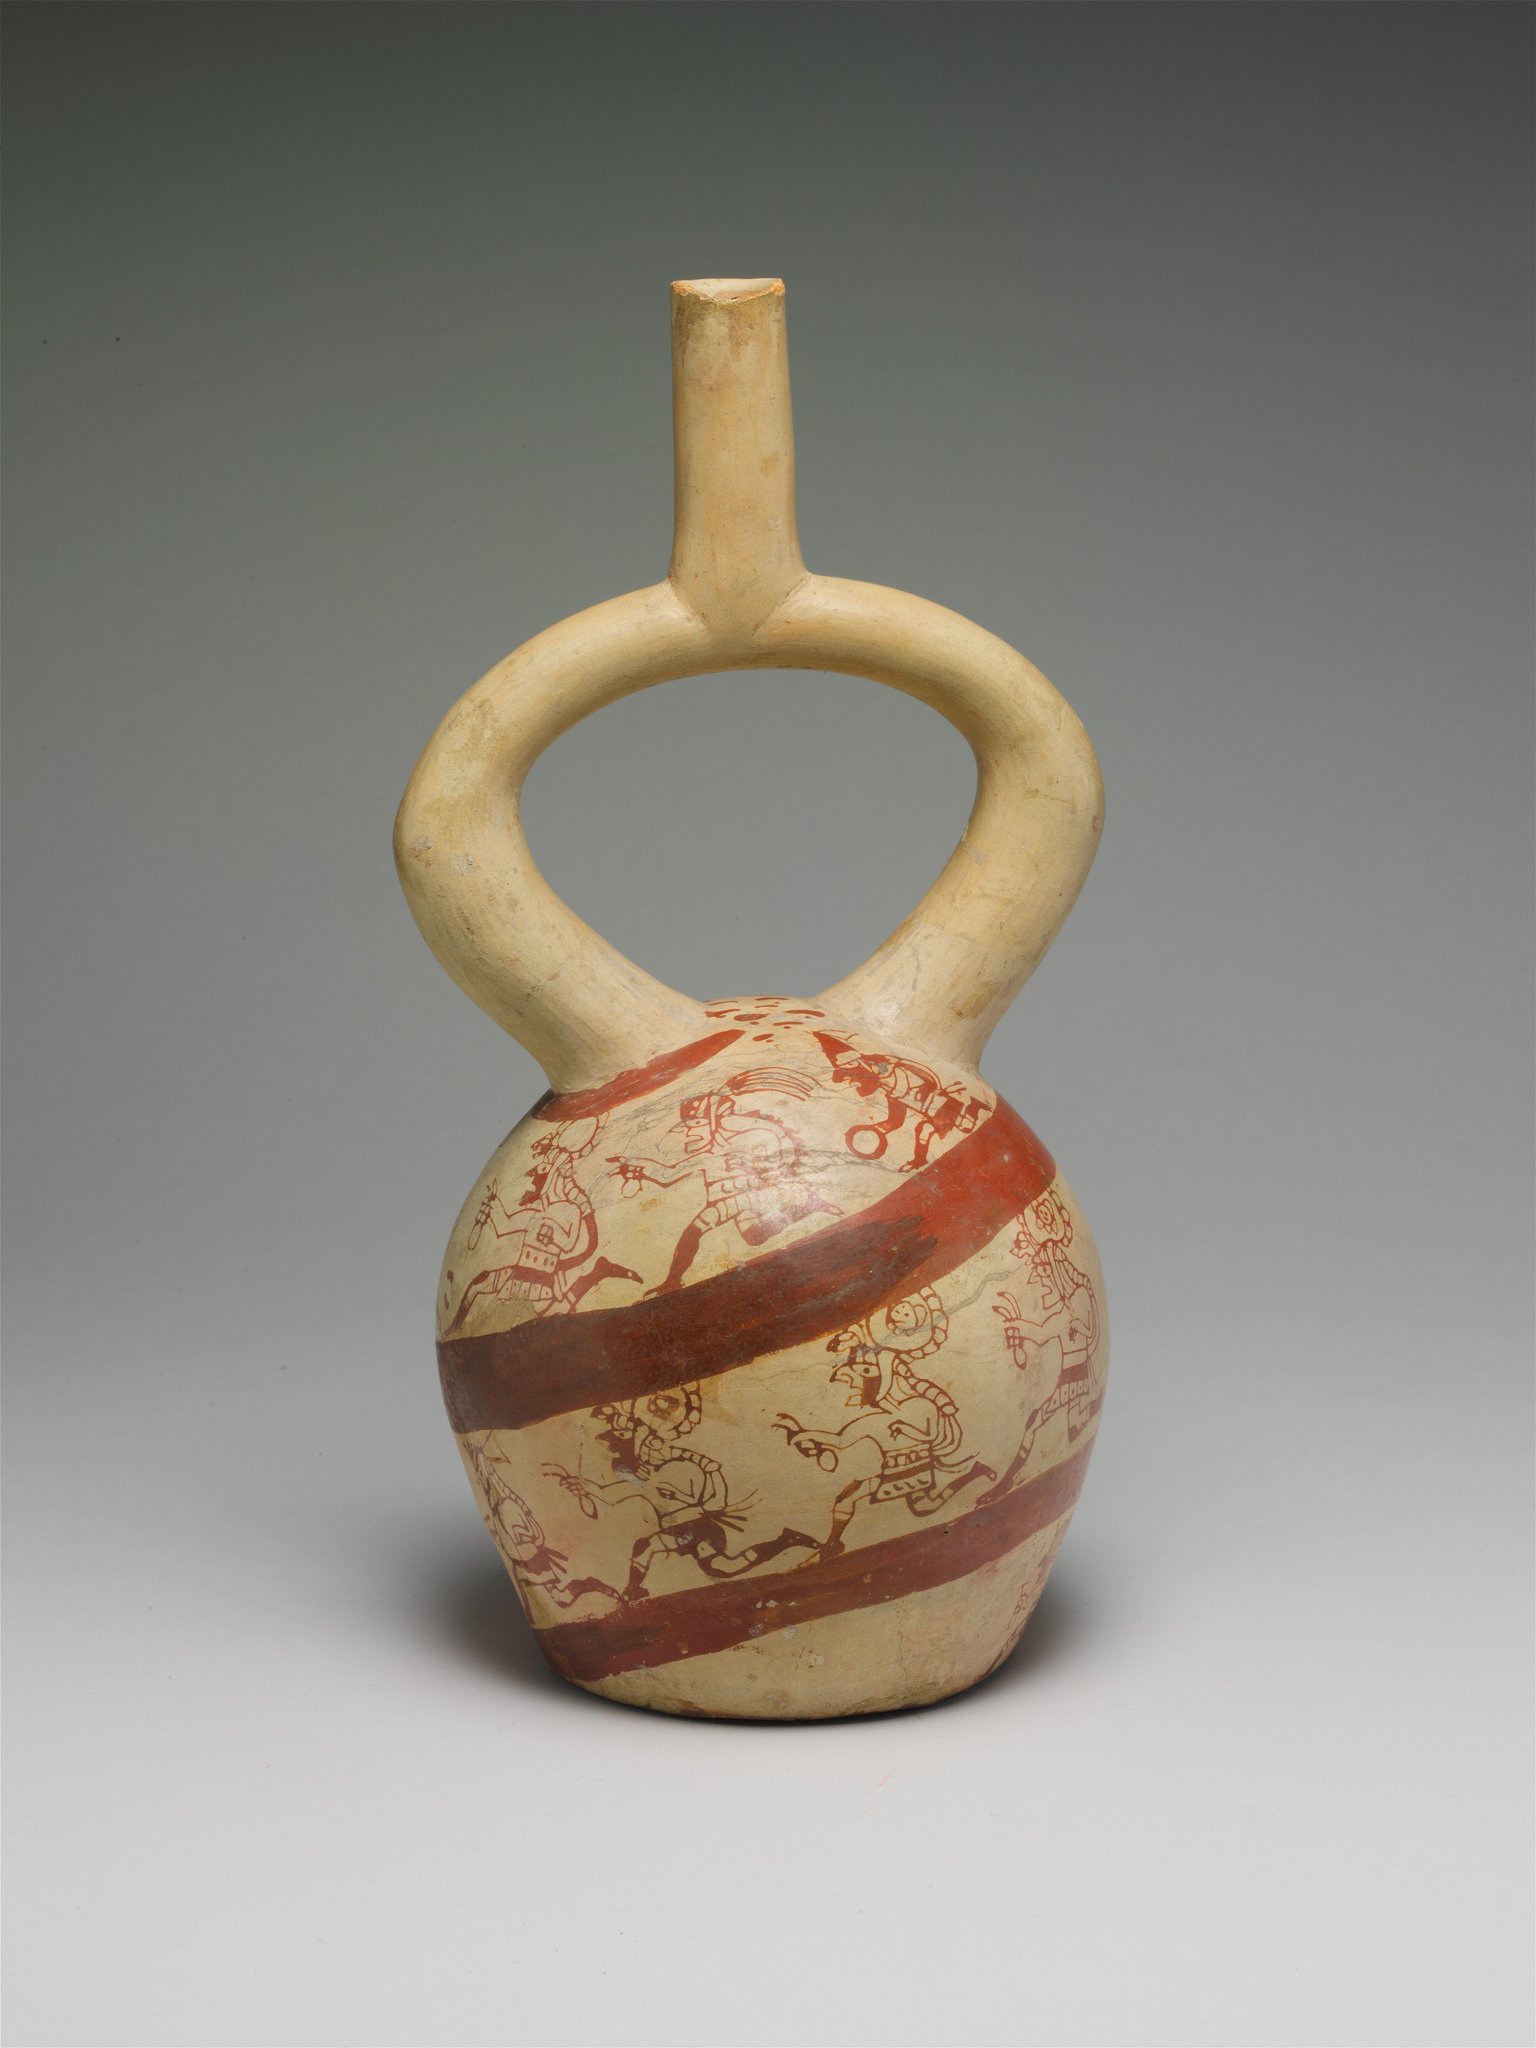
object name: bottle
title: Runners Bottle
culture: moche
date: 301-700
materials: ceramic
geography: peru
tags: men,running